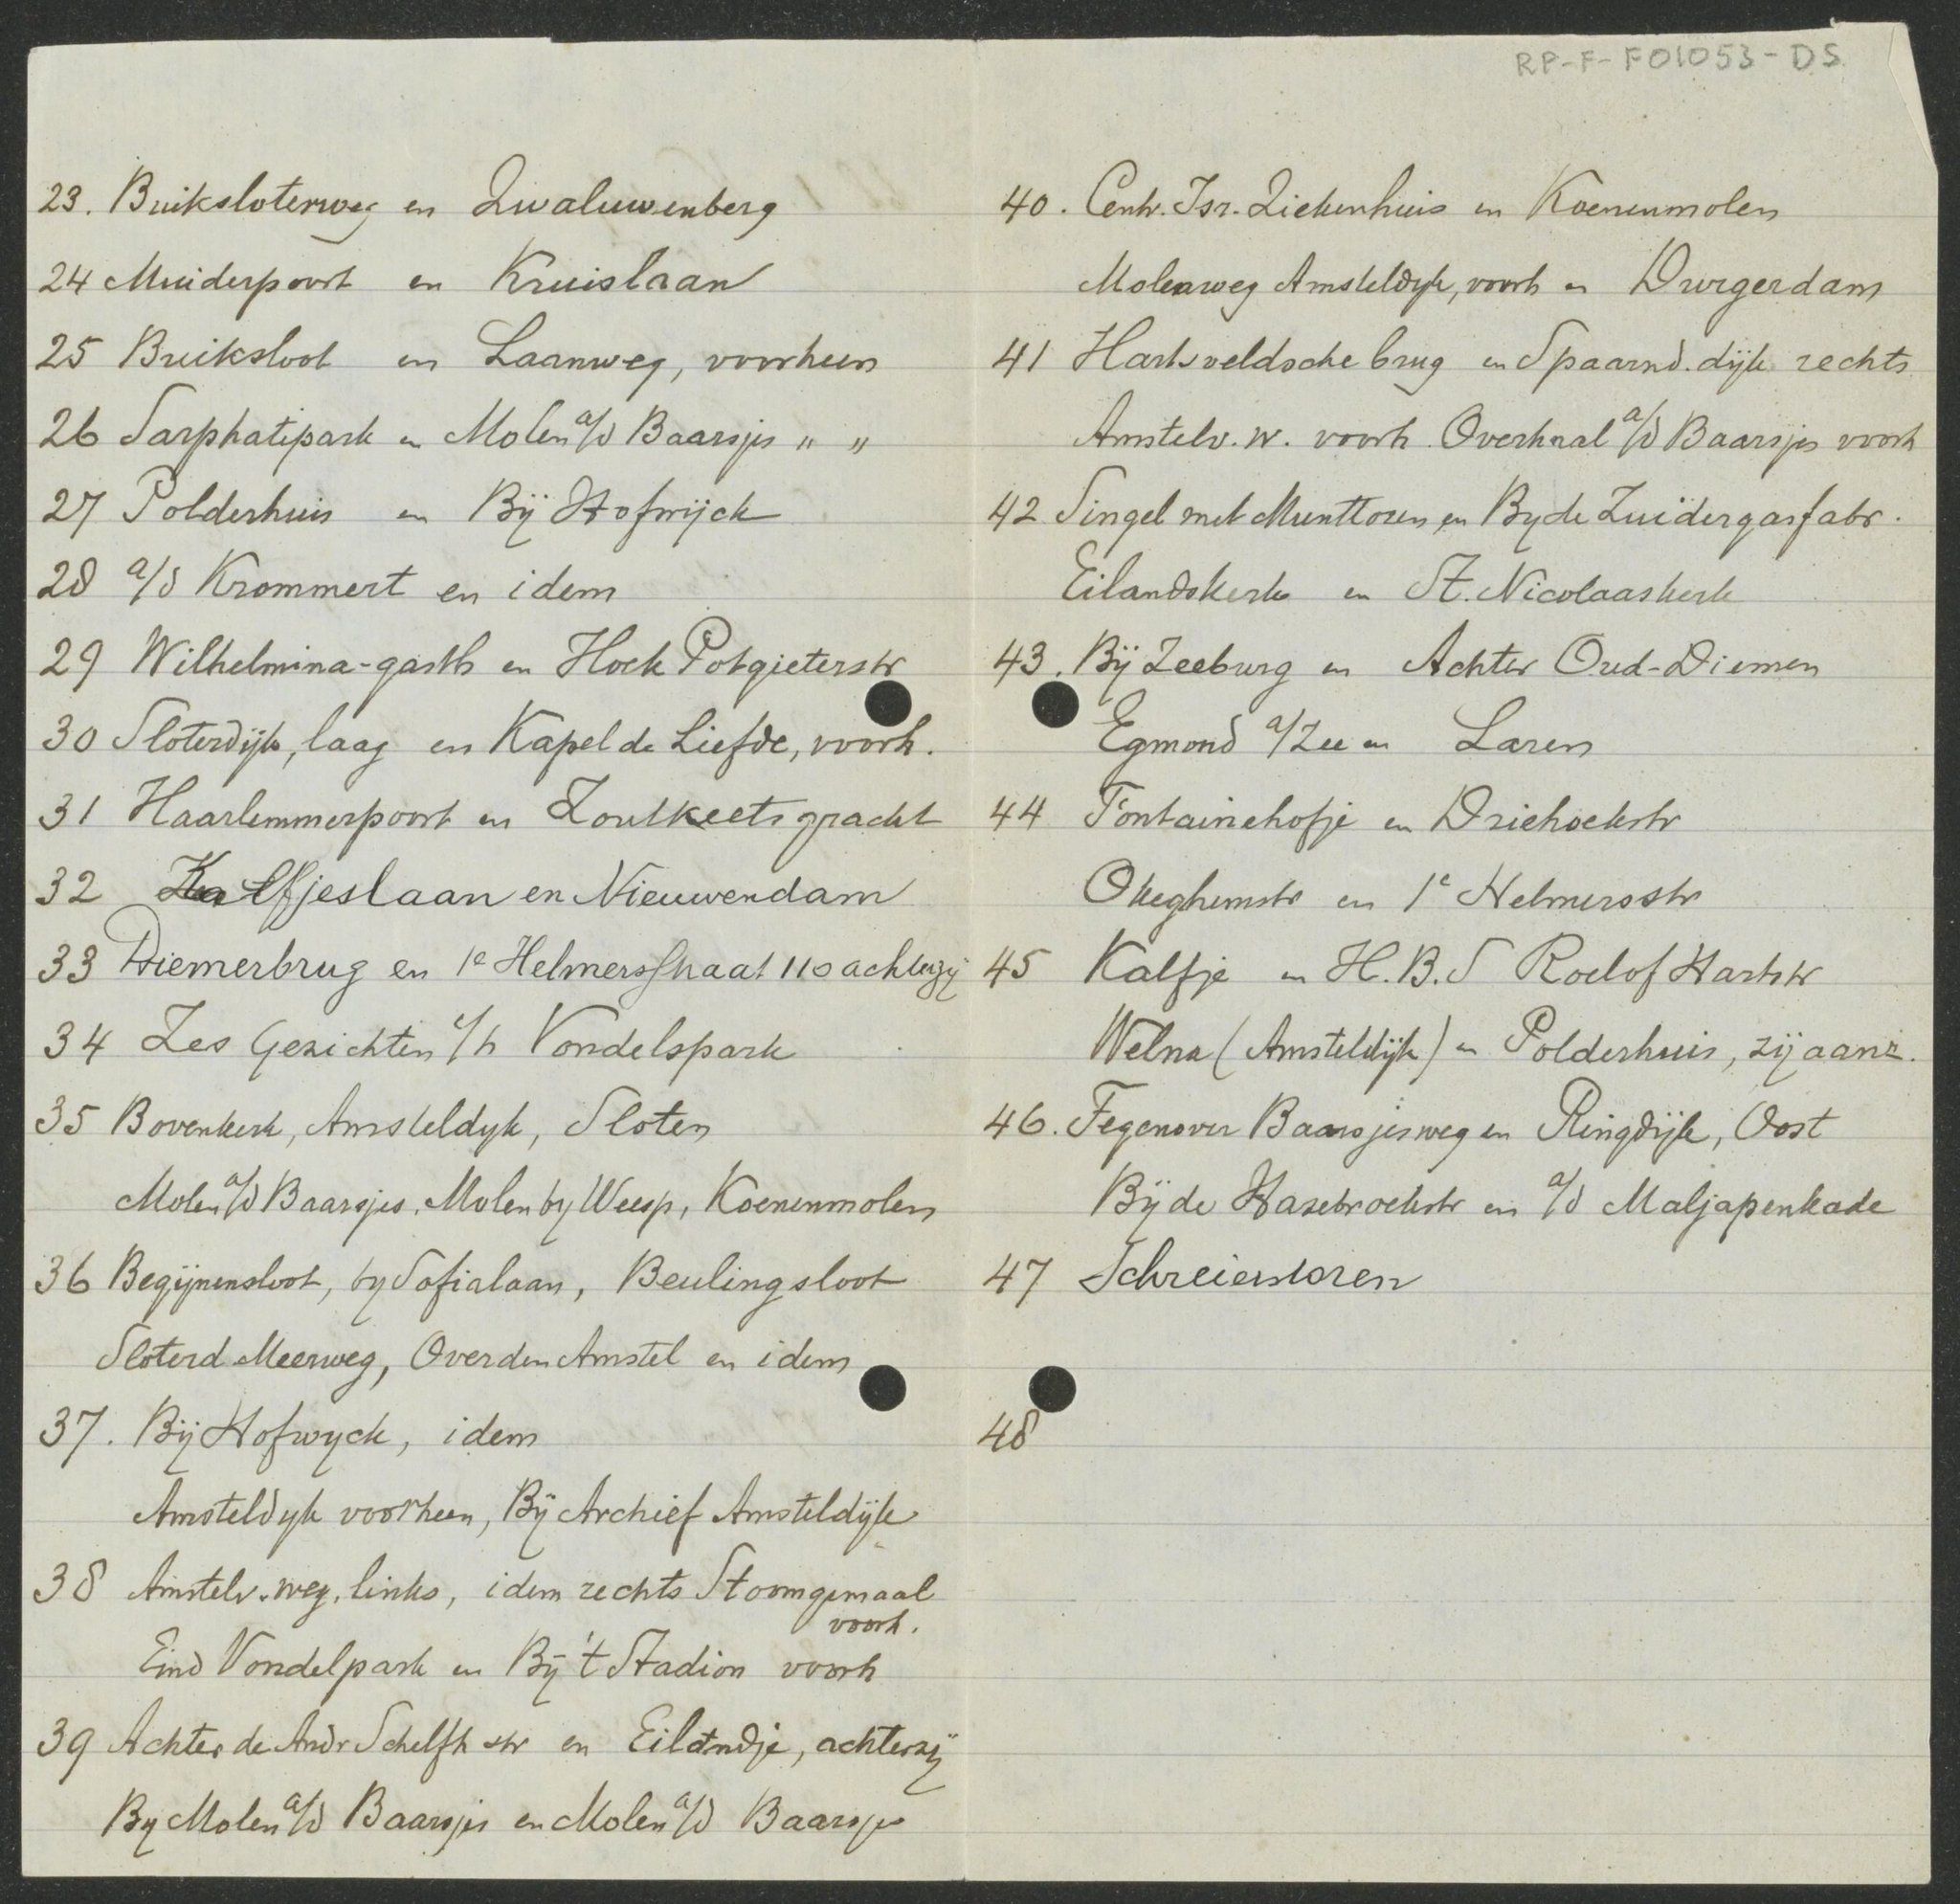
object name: list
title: Lijst met in het album afgebeelde onderwerpen (blad 23 t/m 48)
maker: Anonymous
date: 1930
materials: paper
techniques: writing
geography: netherlands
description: Onderdeel van Album met foto's van Amsterdam en omgeving.